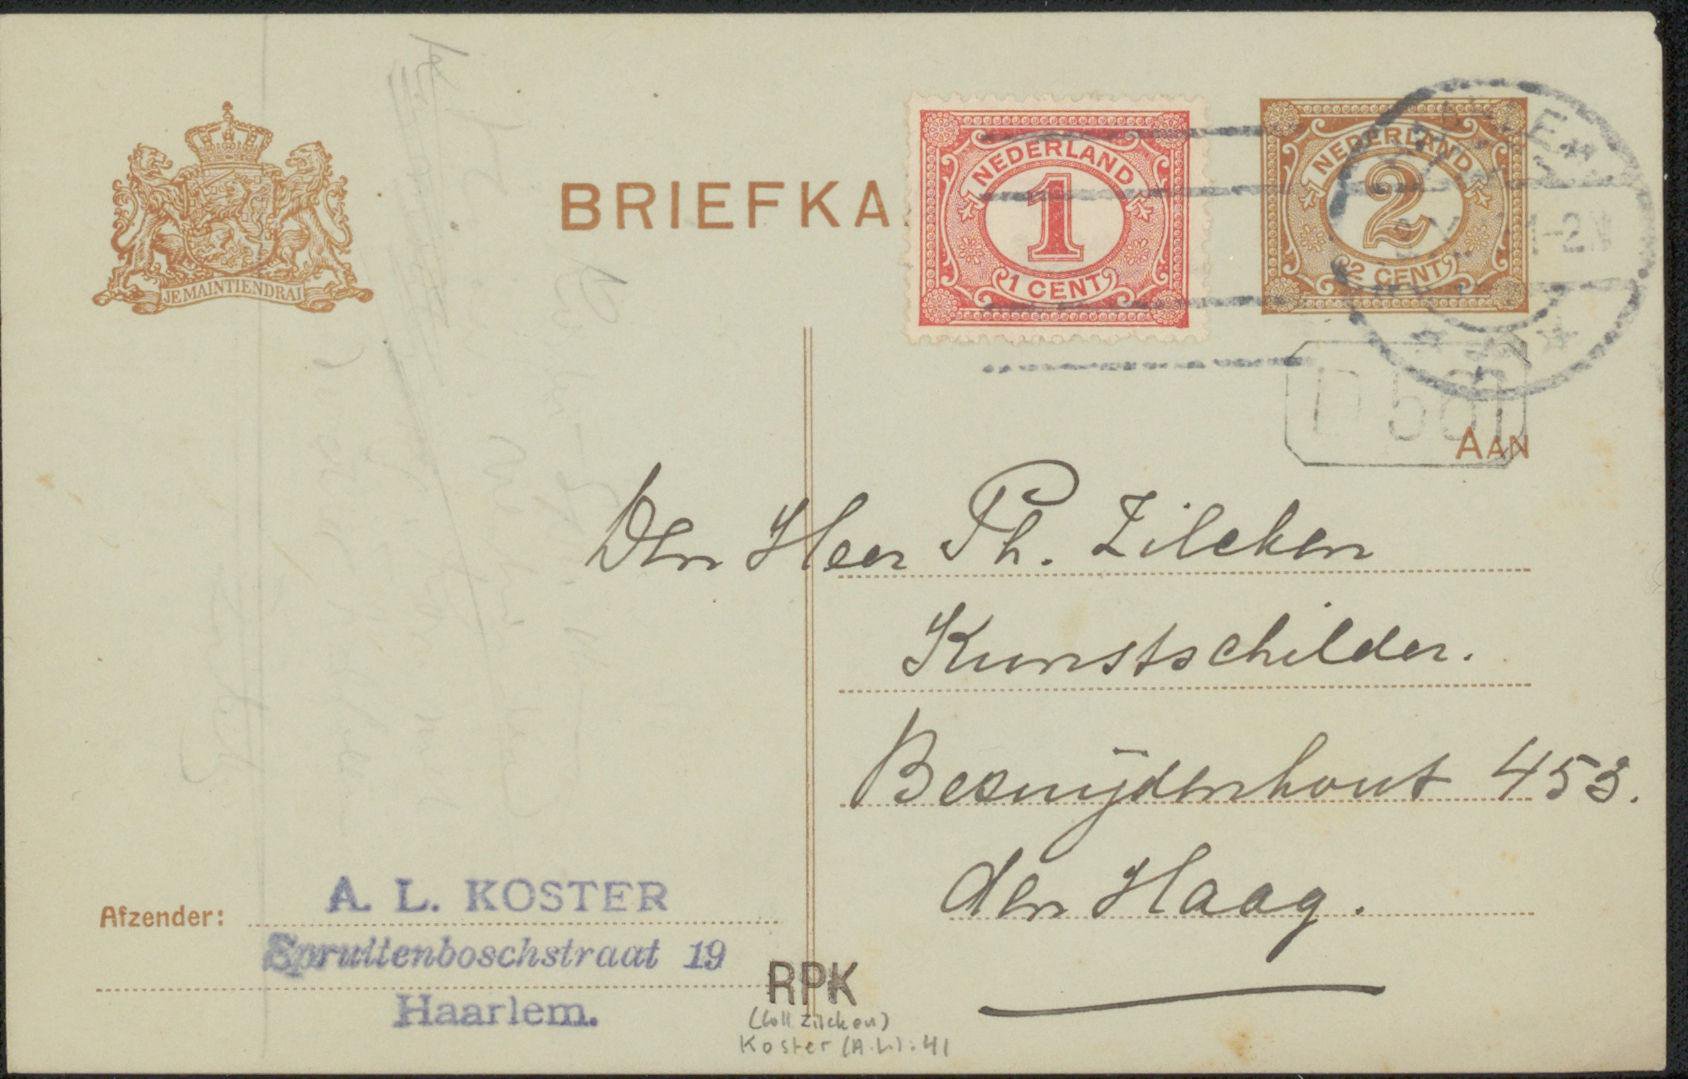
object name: postcard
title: Briefkaart aan Philip Zilcken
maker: anton l. koster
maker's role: draughtsman, painter, print maker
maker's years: 1859-1937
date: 1918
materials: cardboard, ink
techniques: pen, writing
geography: haarlem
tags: arnhem, publisher, martinus nijhoff, the hague, painter, draughtsman, philip zilcken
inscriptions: collector's mark: ‘RPK’, address: ‘A.L. KOSTER/ Spruitenboschstraat 19/ Haarlem.’